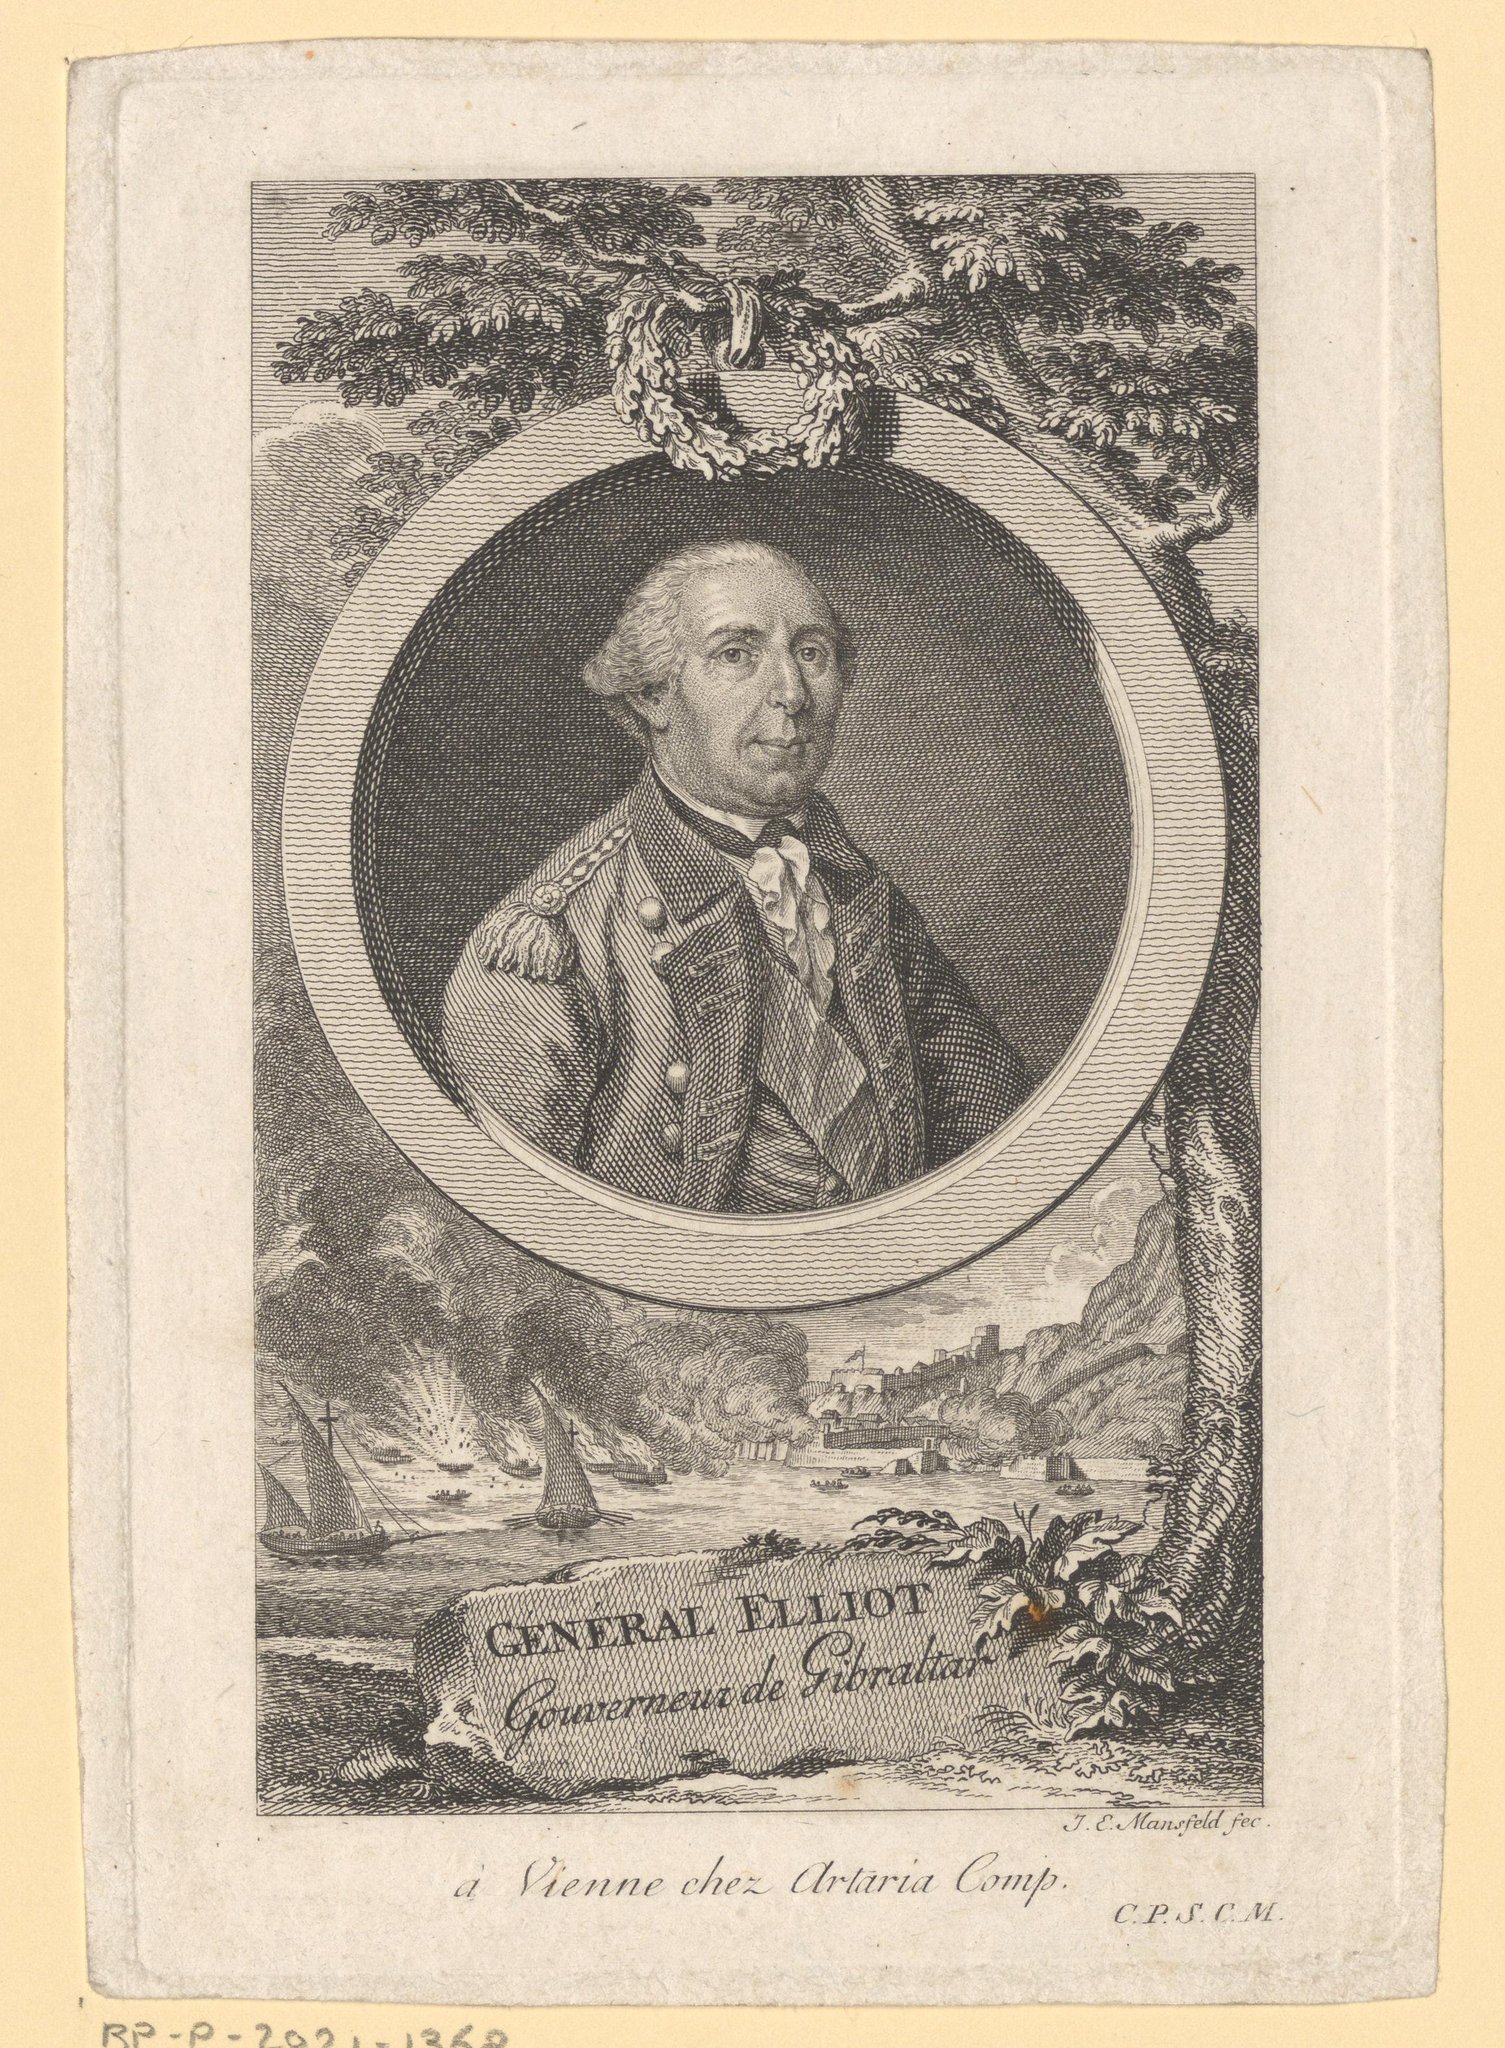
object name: print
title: Portret van George Augustus Eliott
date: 1770-1796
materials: paper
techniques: engraving, etching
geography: vienna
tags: george augustus eliott, historical persons, officer